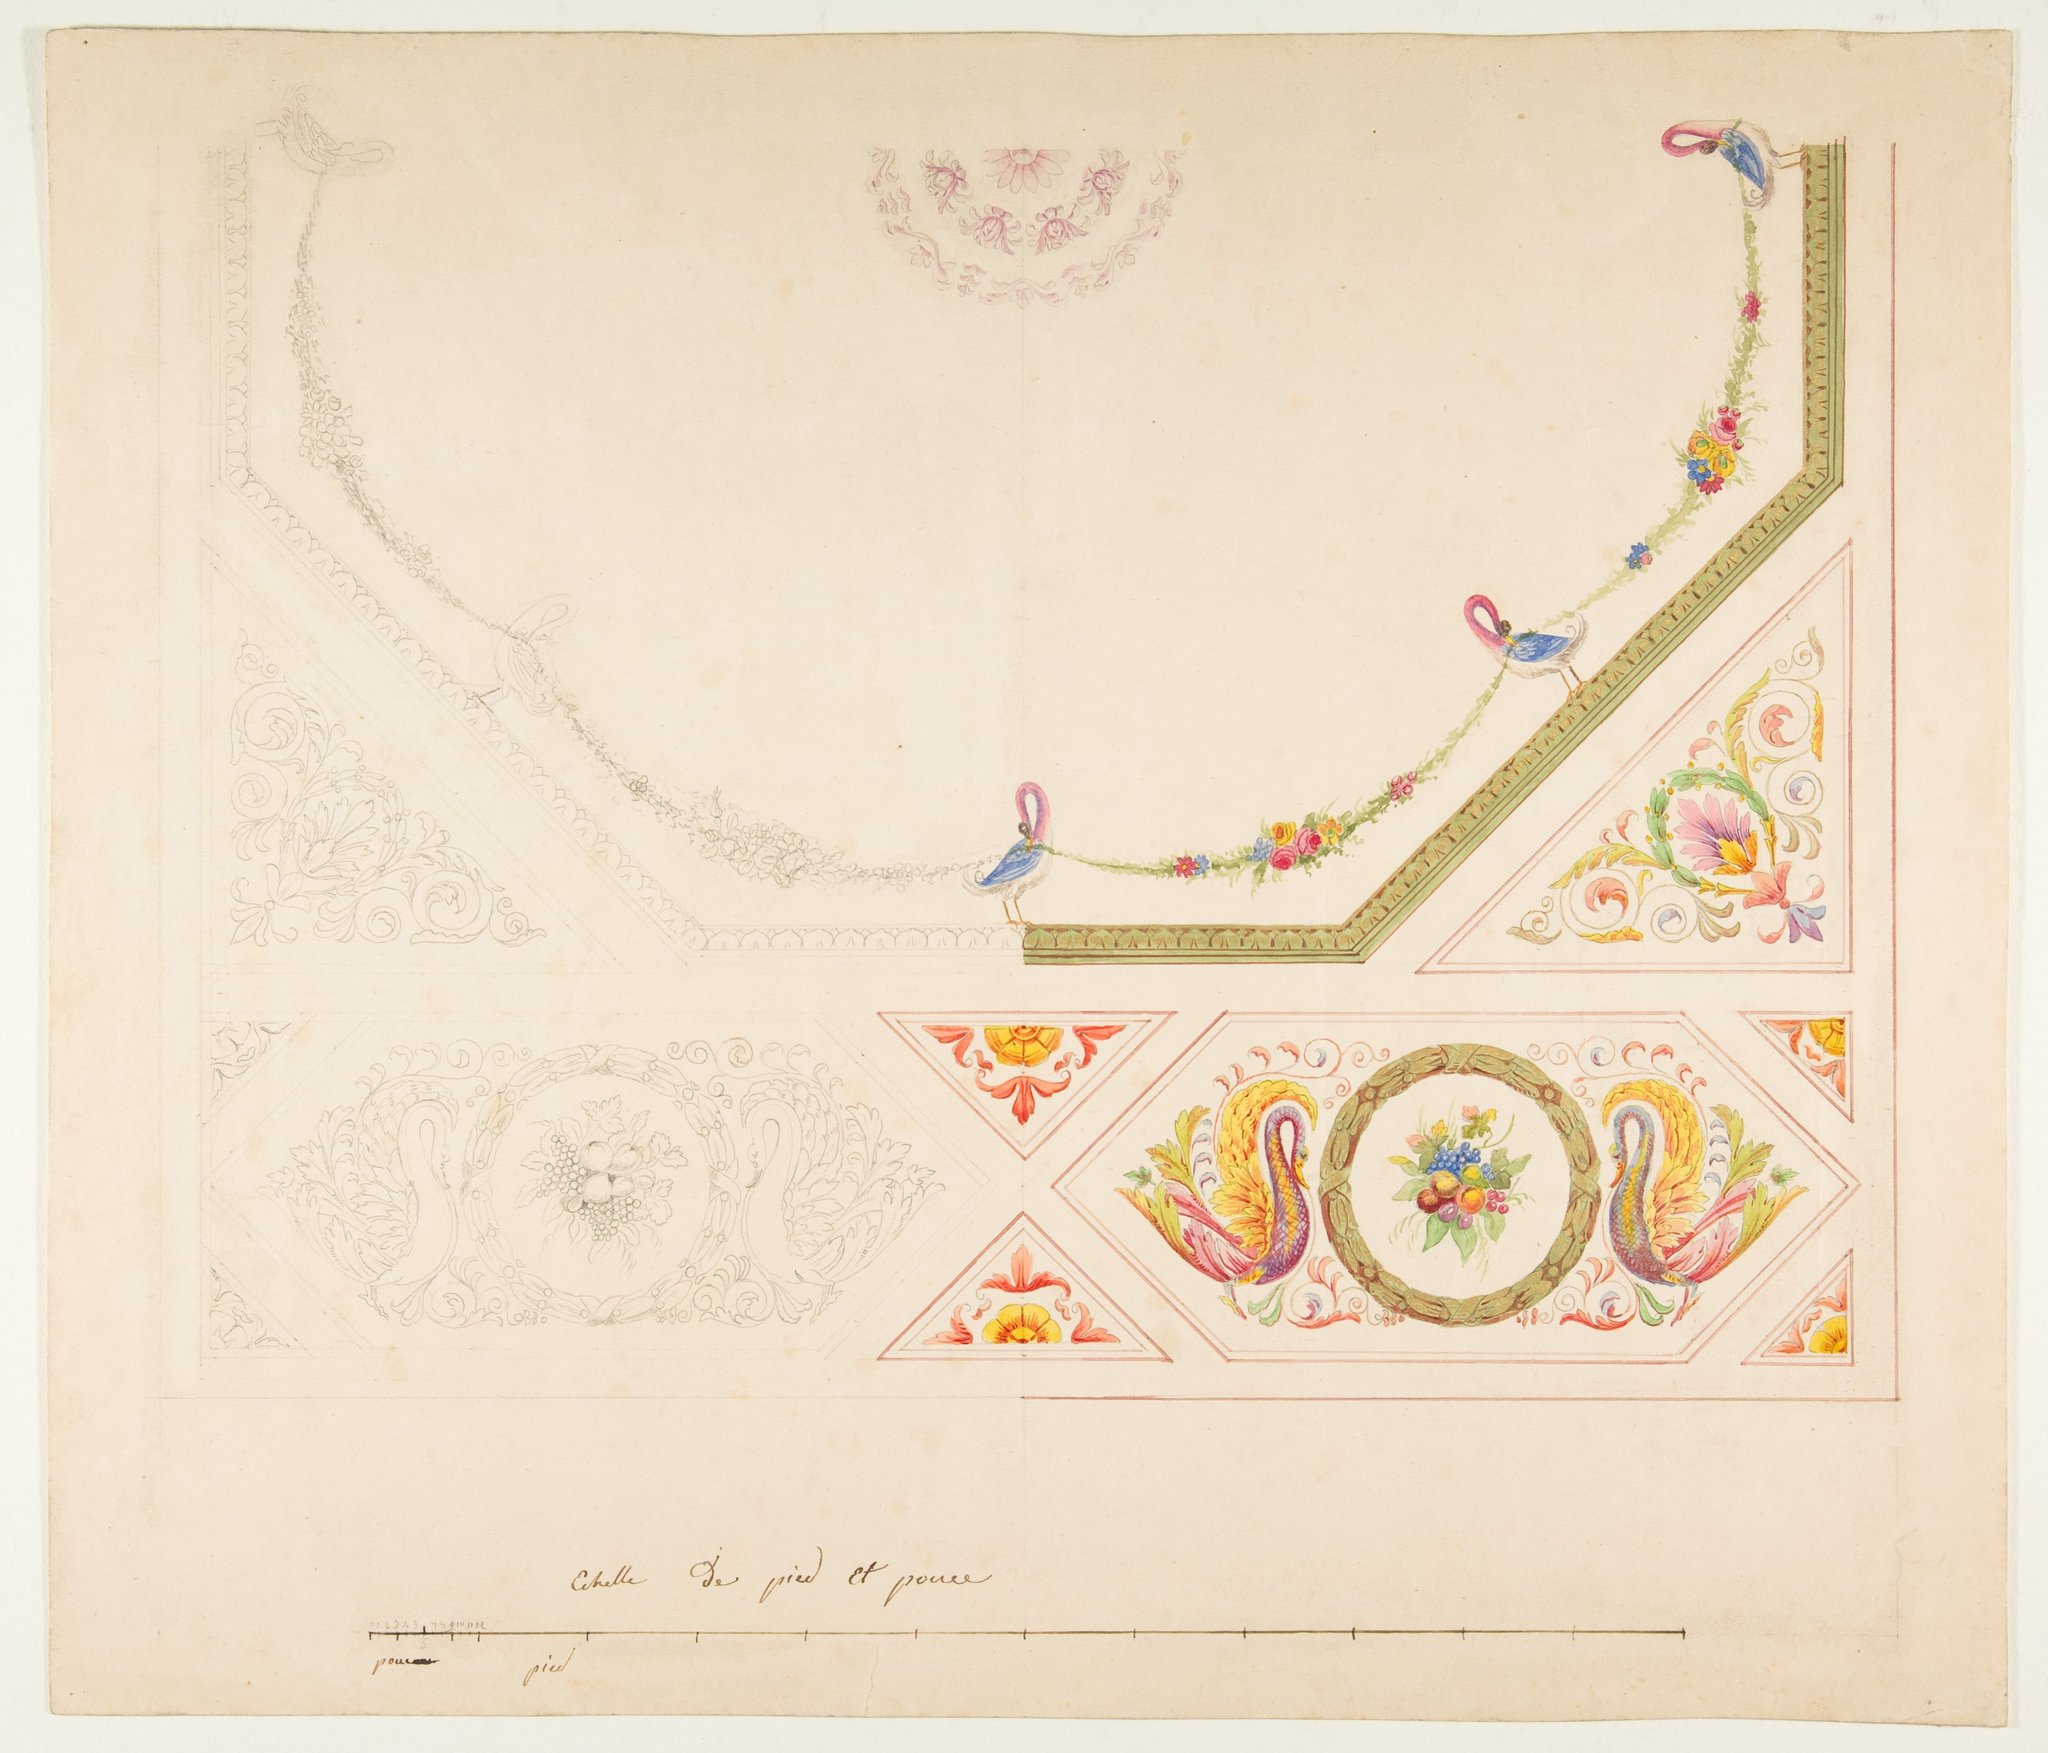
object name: drawing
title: Design for a Ceiling with Swans and Cornucopias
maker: anonymous, french, 19th century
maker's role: artist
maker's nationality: french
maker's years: 1800-1900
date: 1801-1900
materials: gilt, gold, gouache, graphite, ink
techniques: pen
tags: swans,cornucopia